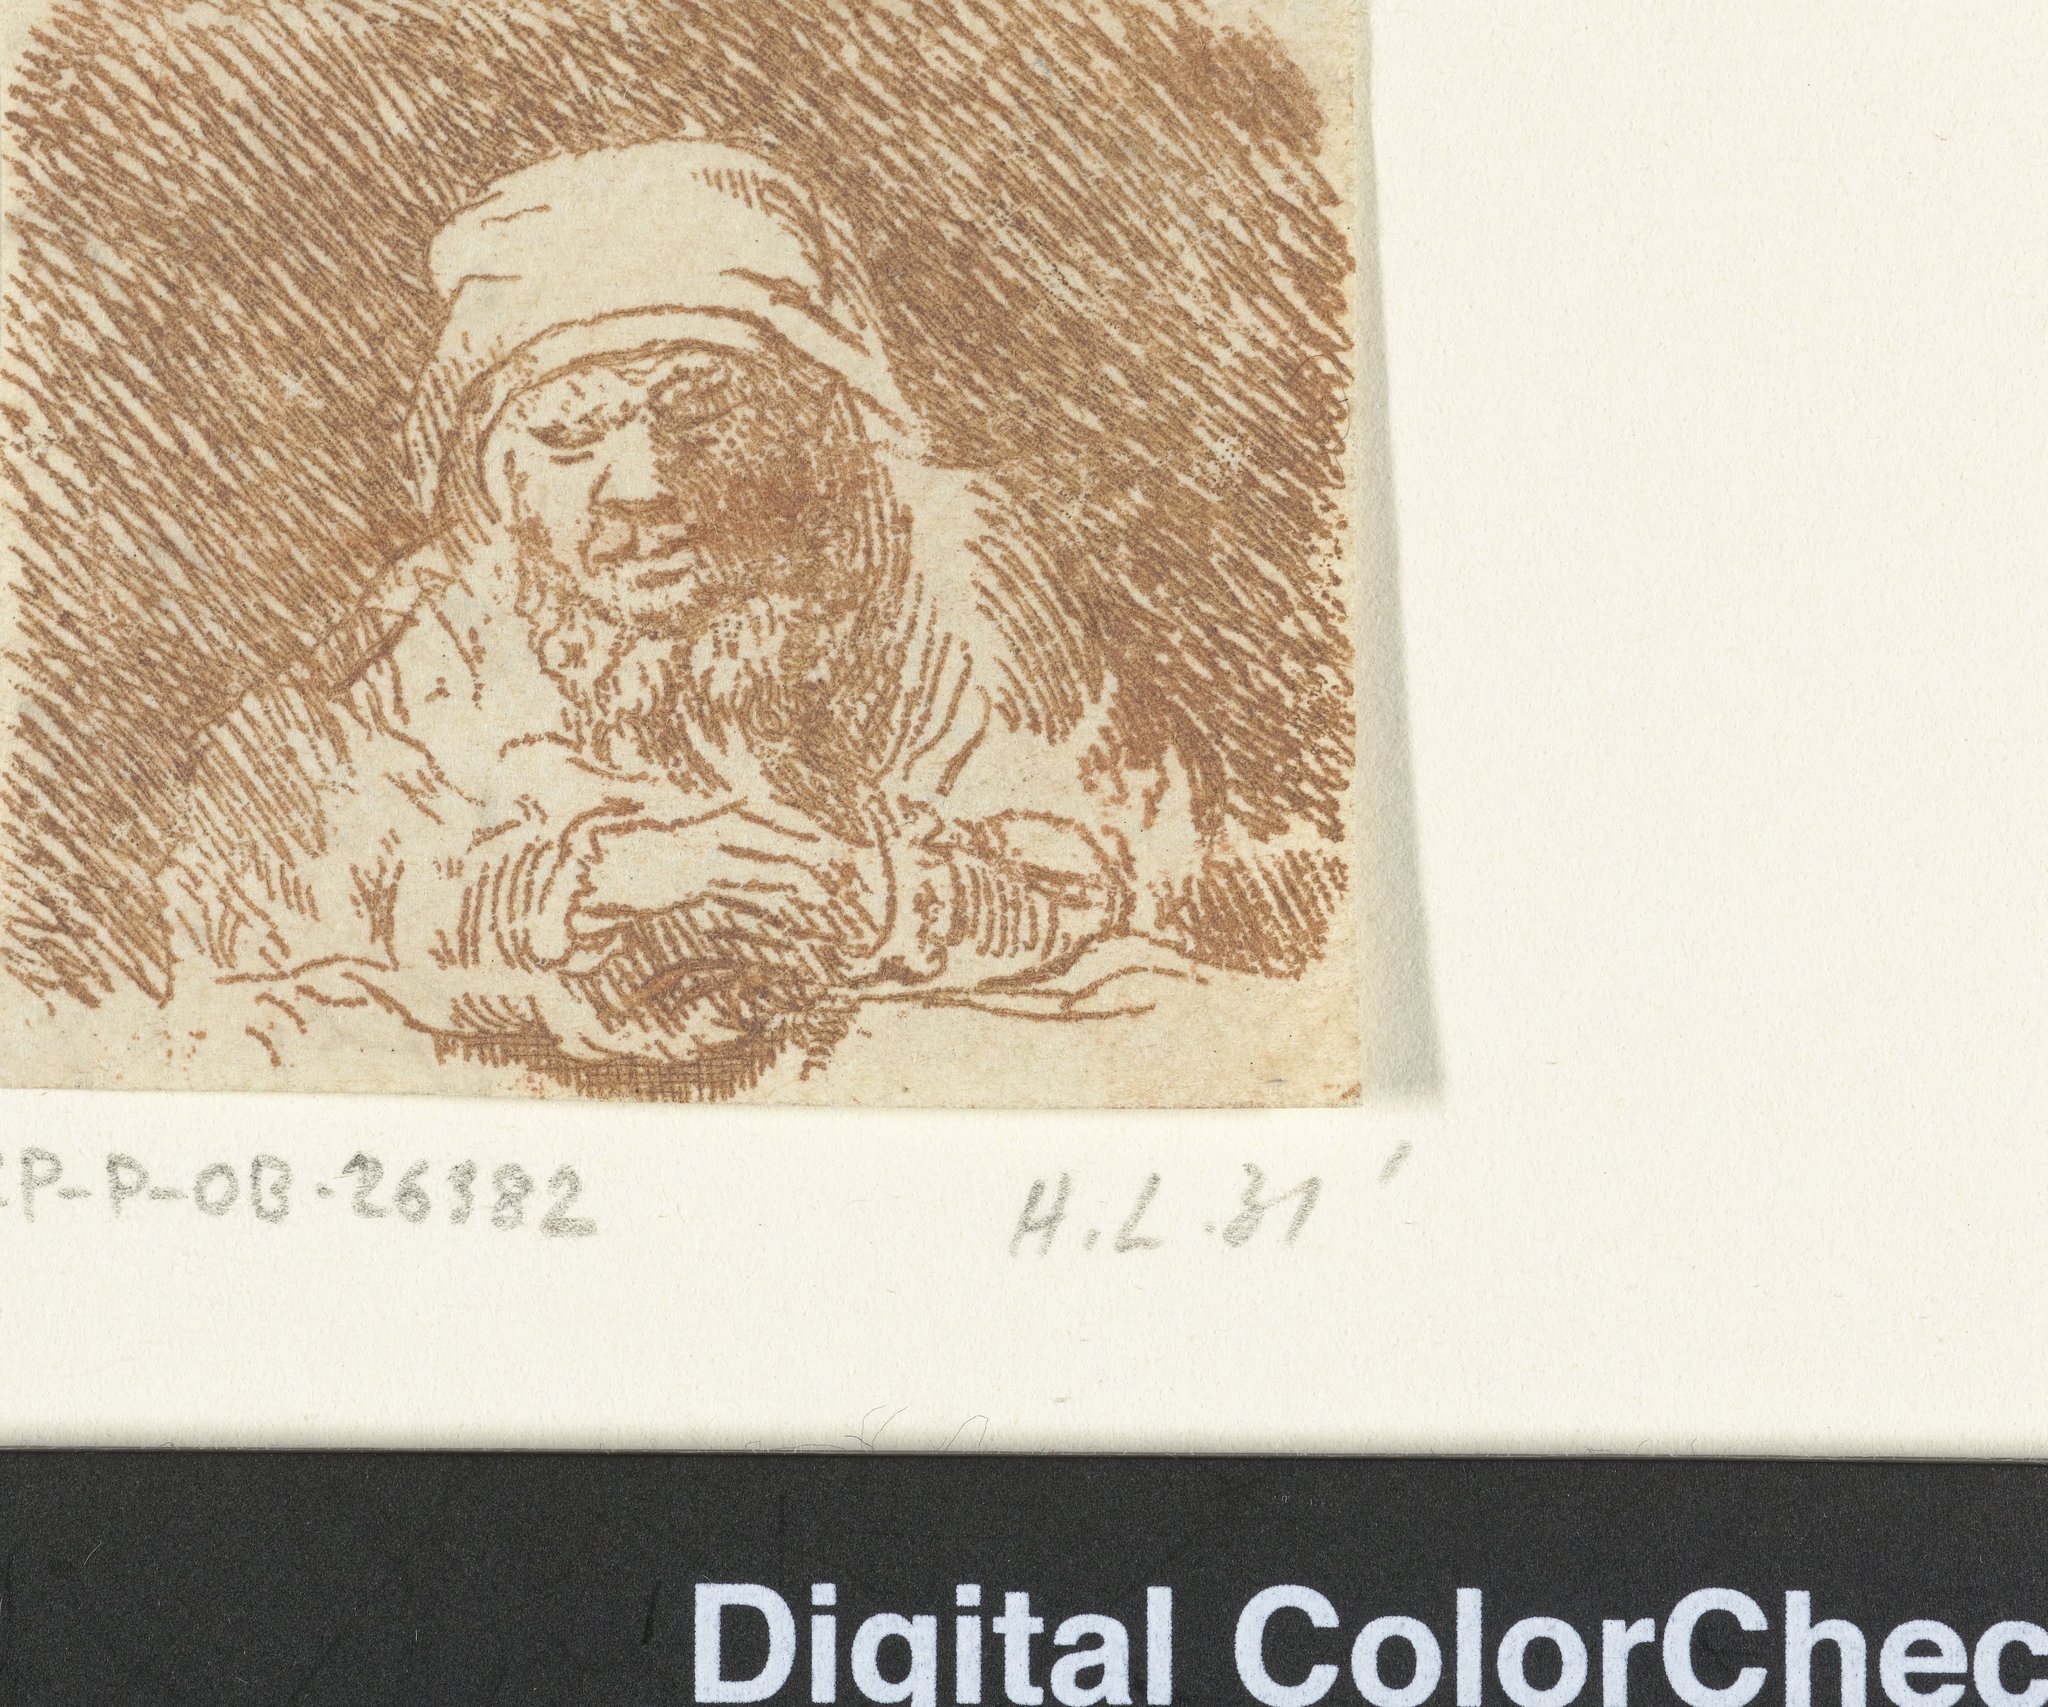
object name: print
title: Slapende oude man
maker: ernst willem jan bagelaar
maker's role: draughtsman, print maker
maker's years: 1775-1837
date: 1798-1837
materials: paper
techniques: etching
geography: netherlands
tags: old man